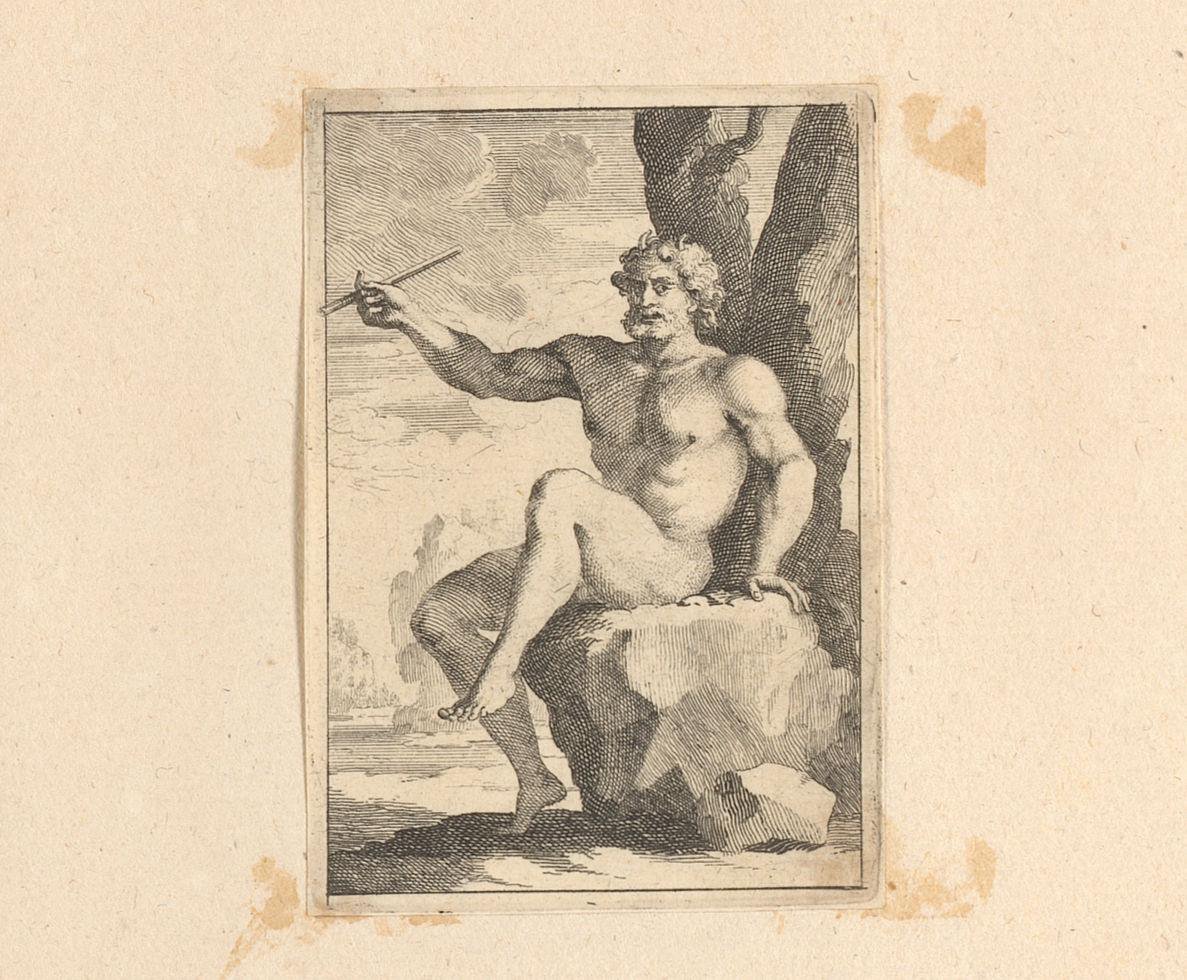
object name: album leaf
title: Tekenvoorbeelden van goden en helden uit de klassieke oudheid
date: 1665-1673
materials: paper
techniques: etching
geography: paris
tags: model-books ~ implements of painter, (story of) pan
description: Maakt deel uit van een 32-delige serie met tekenvoorbeelden van goden en helden uit de klassieke oudheid. Een eerste editie werd in 1673 uitgegeven en een tweede in 1684 door Nicolas Langlois.